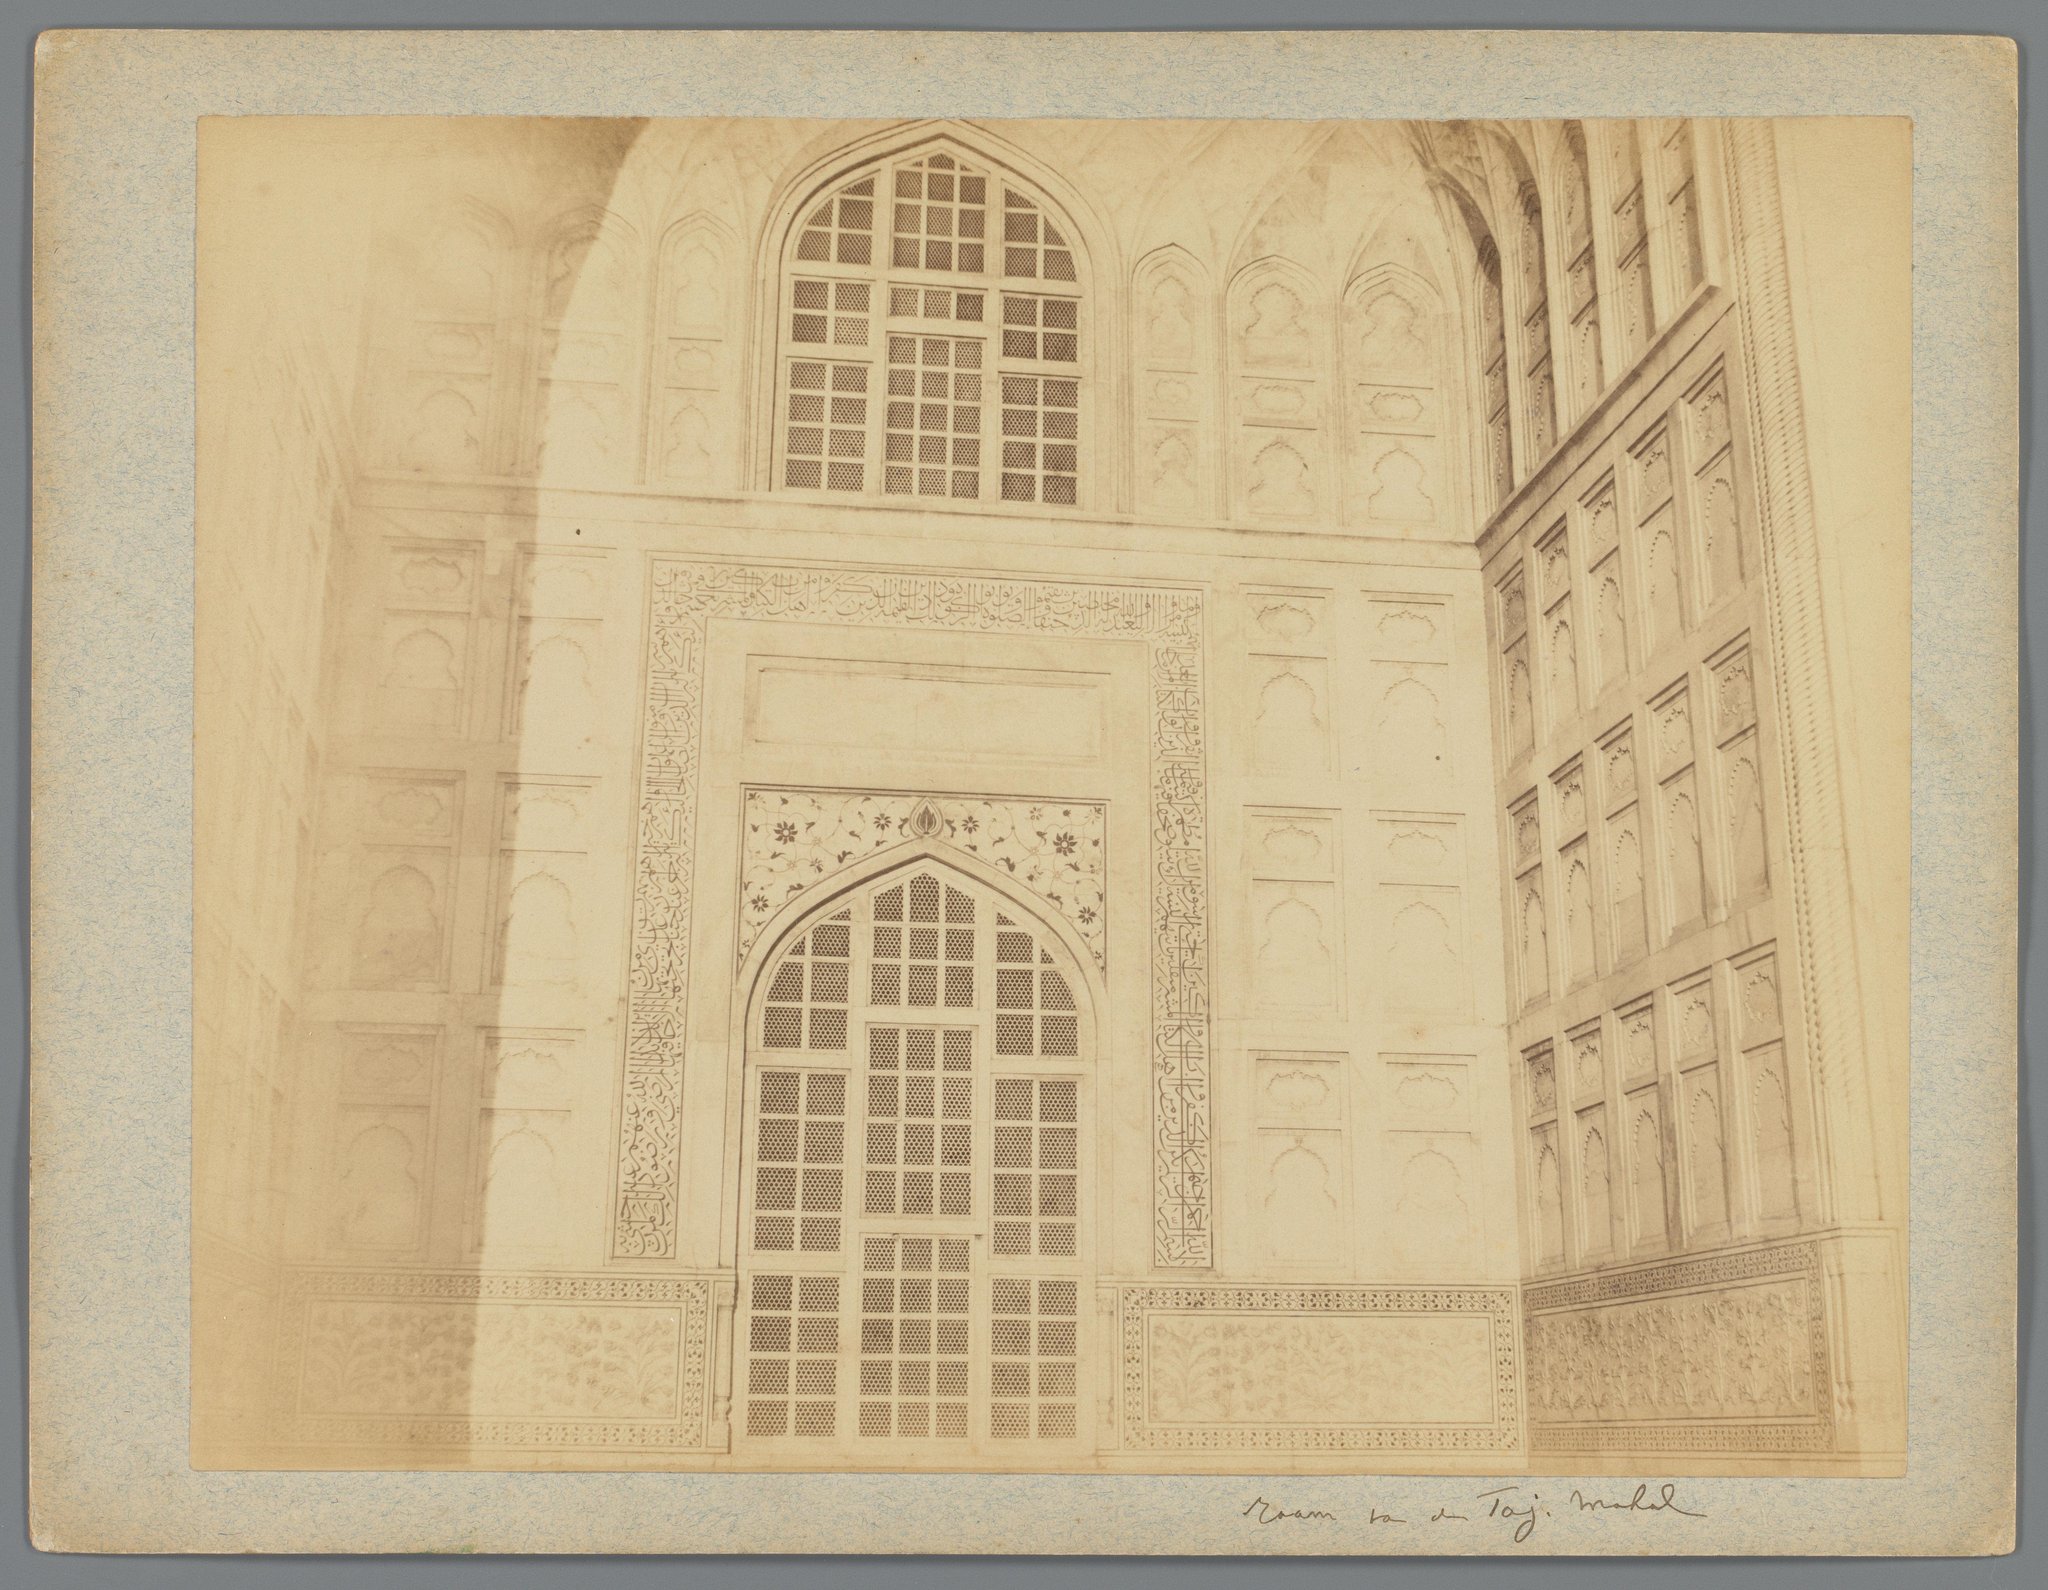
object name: photograph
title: Windows of the Taj Mahal, Agra, Uttar Pradesh, India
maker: Anonymous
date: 1870-1890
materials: cardboard, photographic support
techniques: albumen print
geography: agra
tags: taj mahal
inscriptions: inscription: ‘raam in den Taj Mahal’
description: Op de achterzijde is een schets gemaakt van (een gedeelte van) de Taj Mahal.